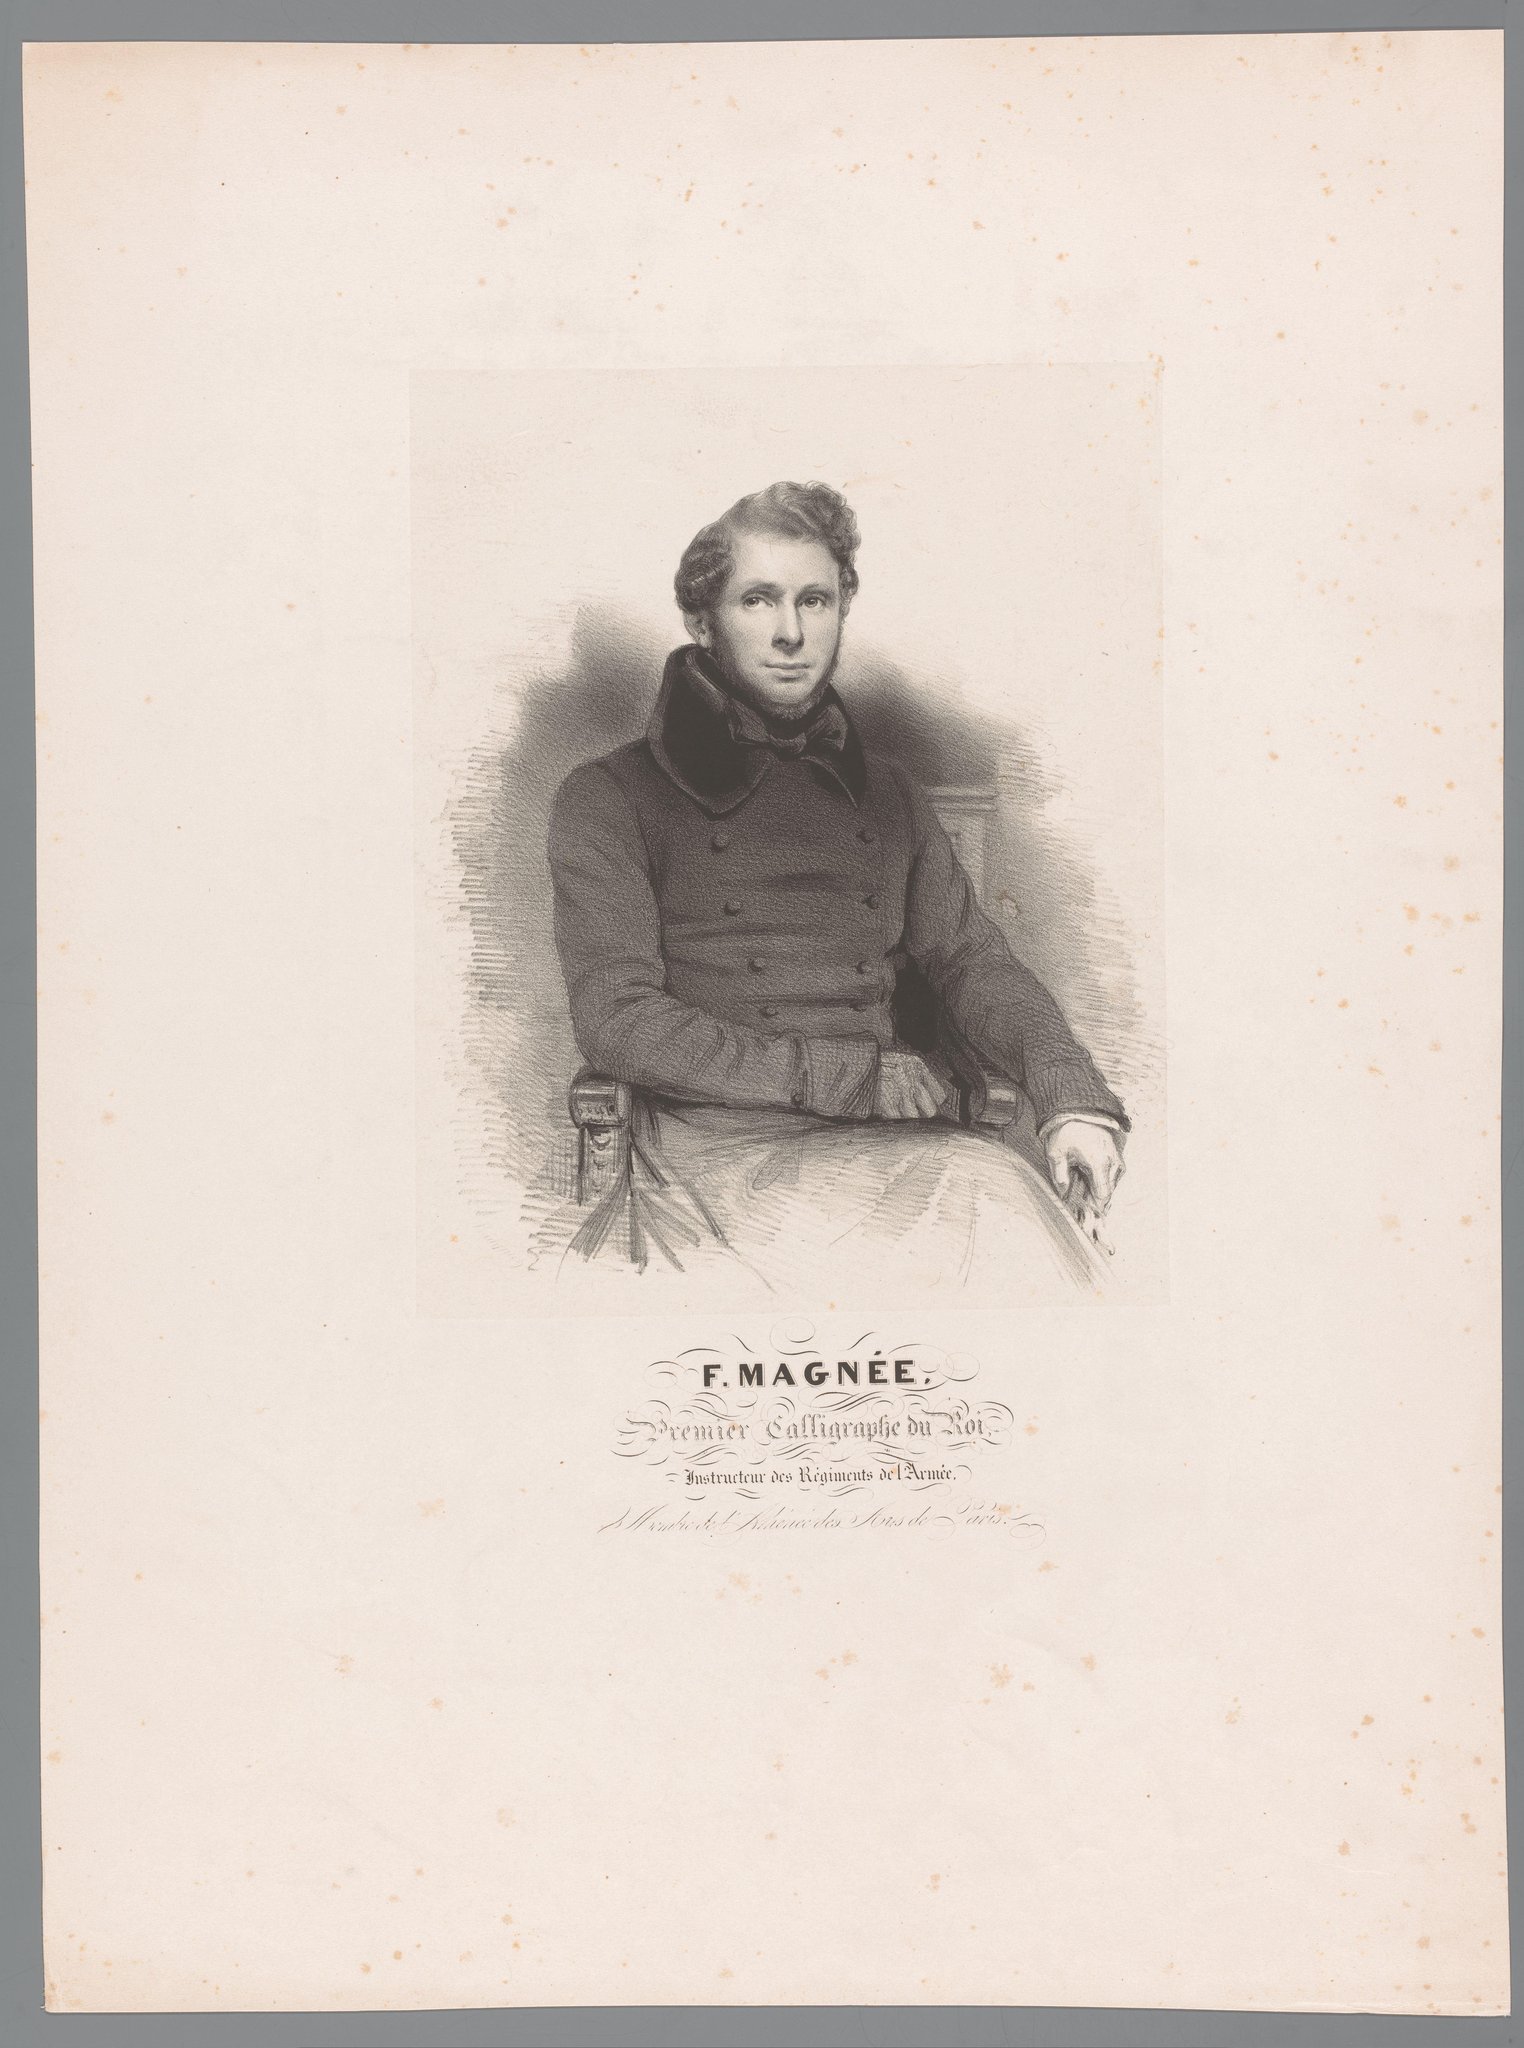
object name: print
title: F. Magnée, premier calligraphe du roi (...) des ars de Paris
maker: charles baugniet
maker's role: print maker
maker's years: 1814-1886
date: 1824-1886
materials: paper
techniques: lithograph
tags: f. magneé, armchair, seat, adult man, historical persons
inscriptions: collector's mark: Lugt 2228